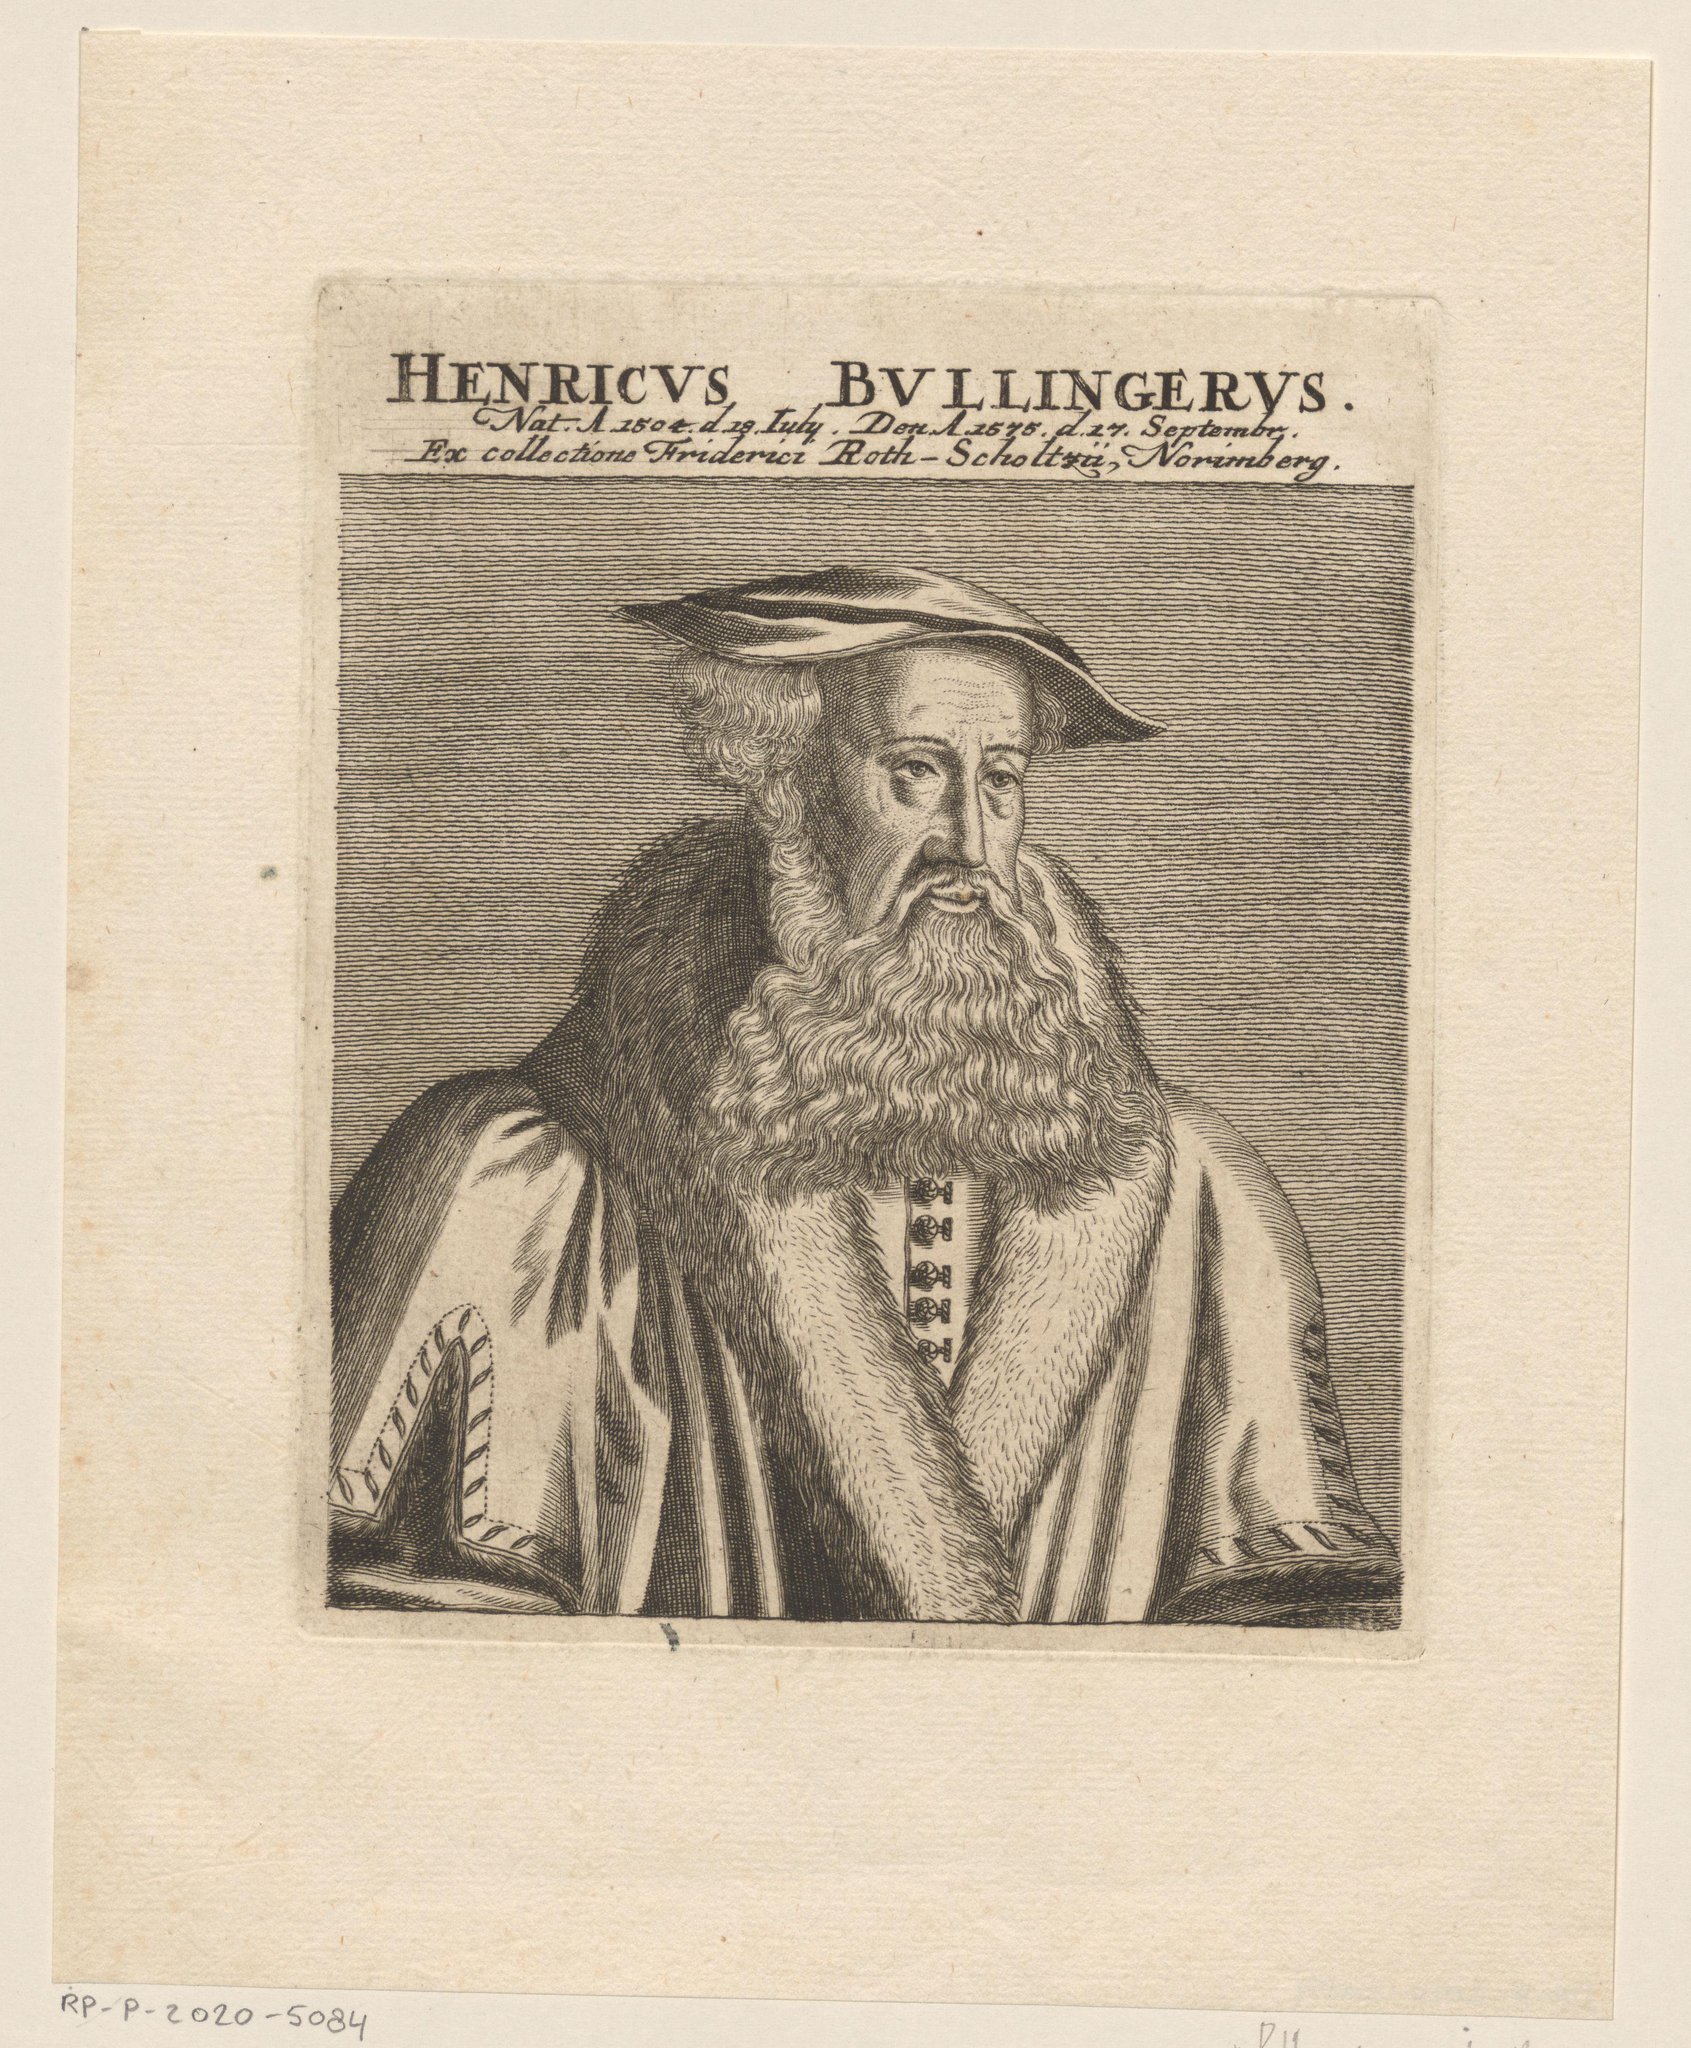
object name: print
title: Portret van Johann Heinrich Bullinger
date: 1726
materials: paper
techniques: engraving, etching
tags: theologian, historical persons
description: Andere staat van deze prent gebruikt in: Rothscholtz, Friedrich. Quinquaginta imagines eruditorum virorum imprimis praestantissimorum aliquot theologorum (...). Altdorff en Neurenberg: Friedrich Tauber, 1726.